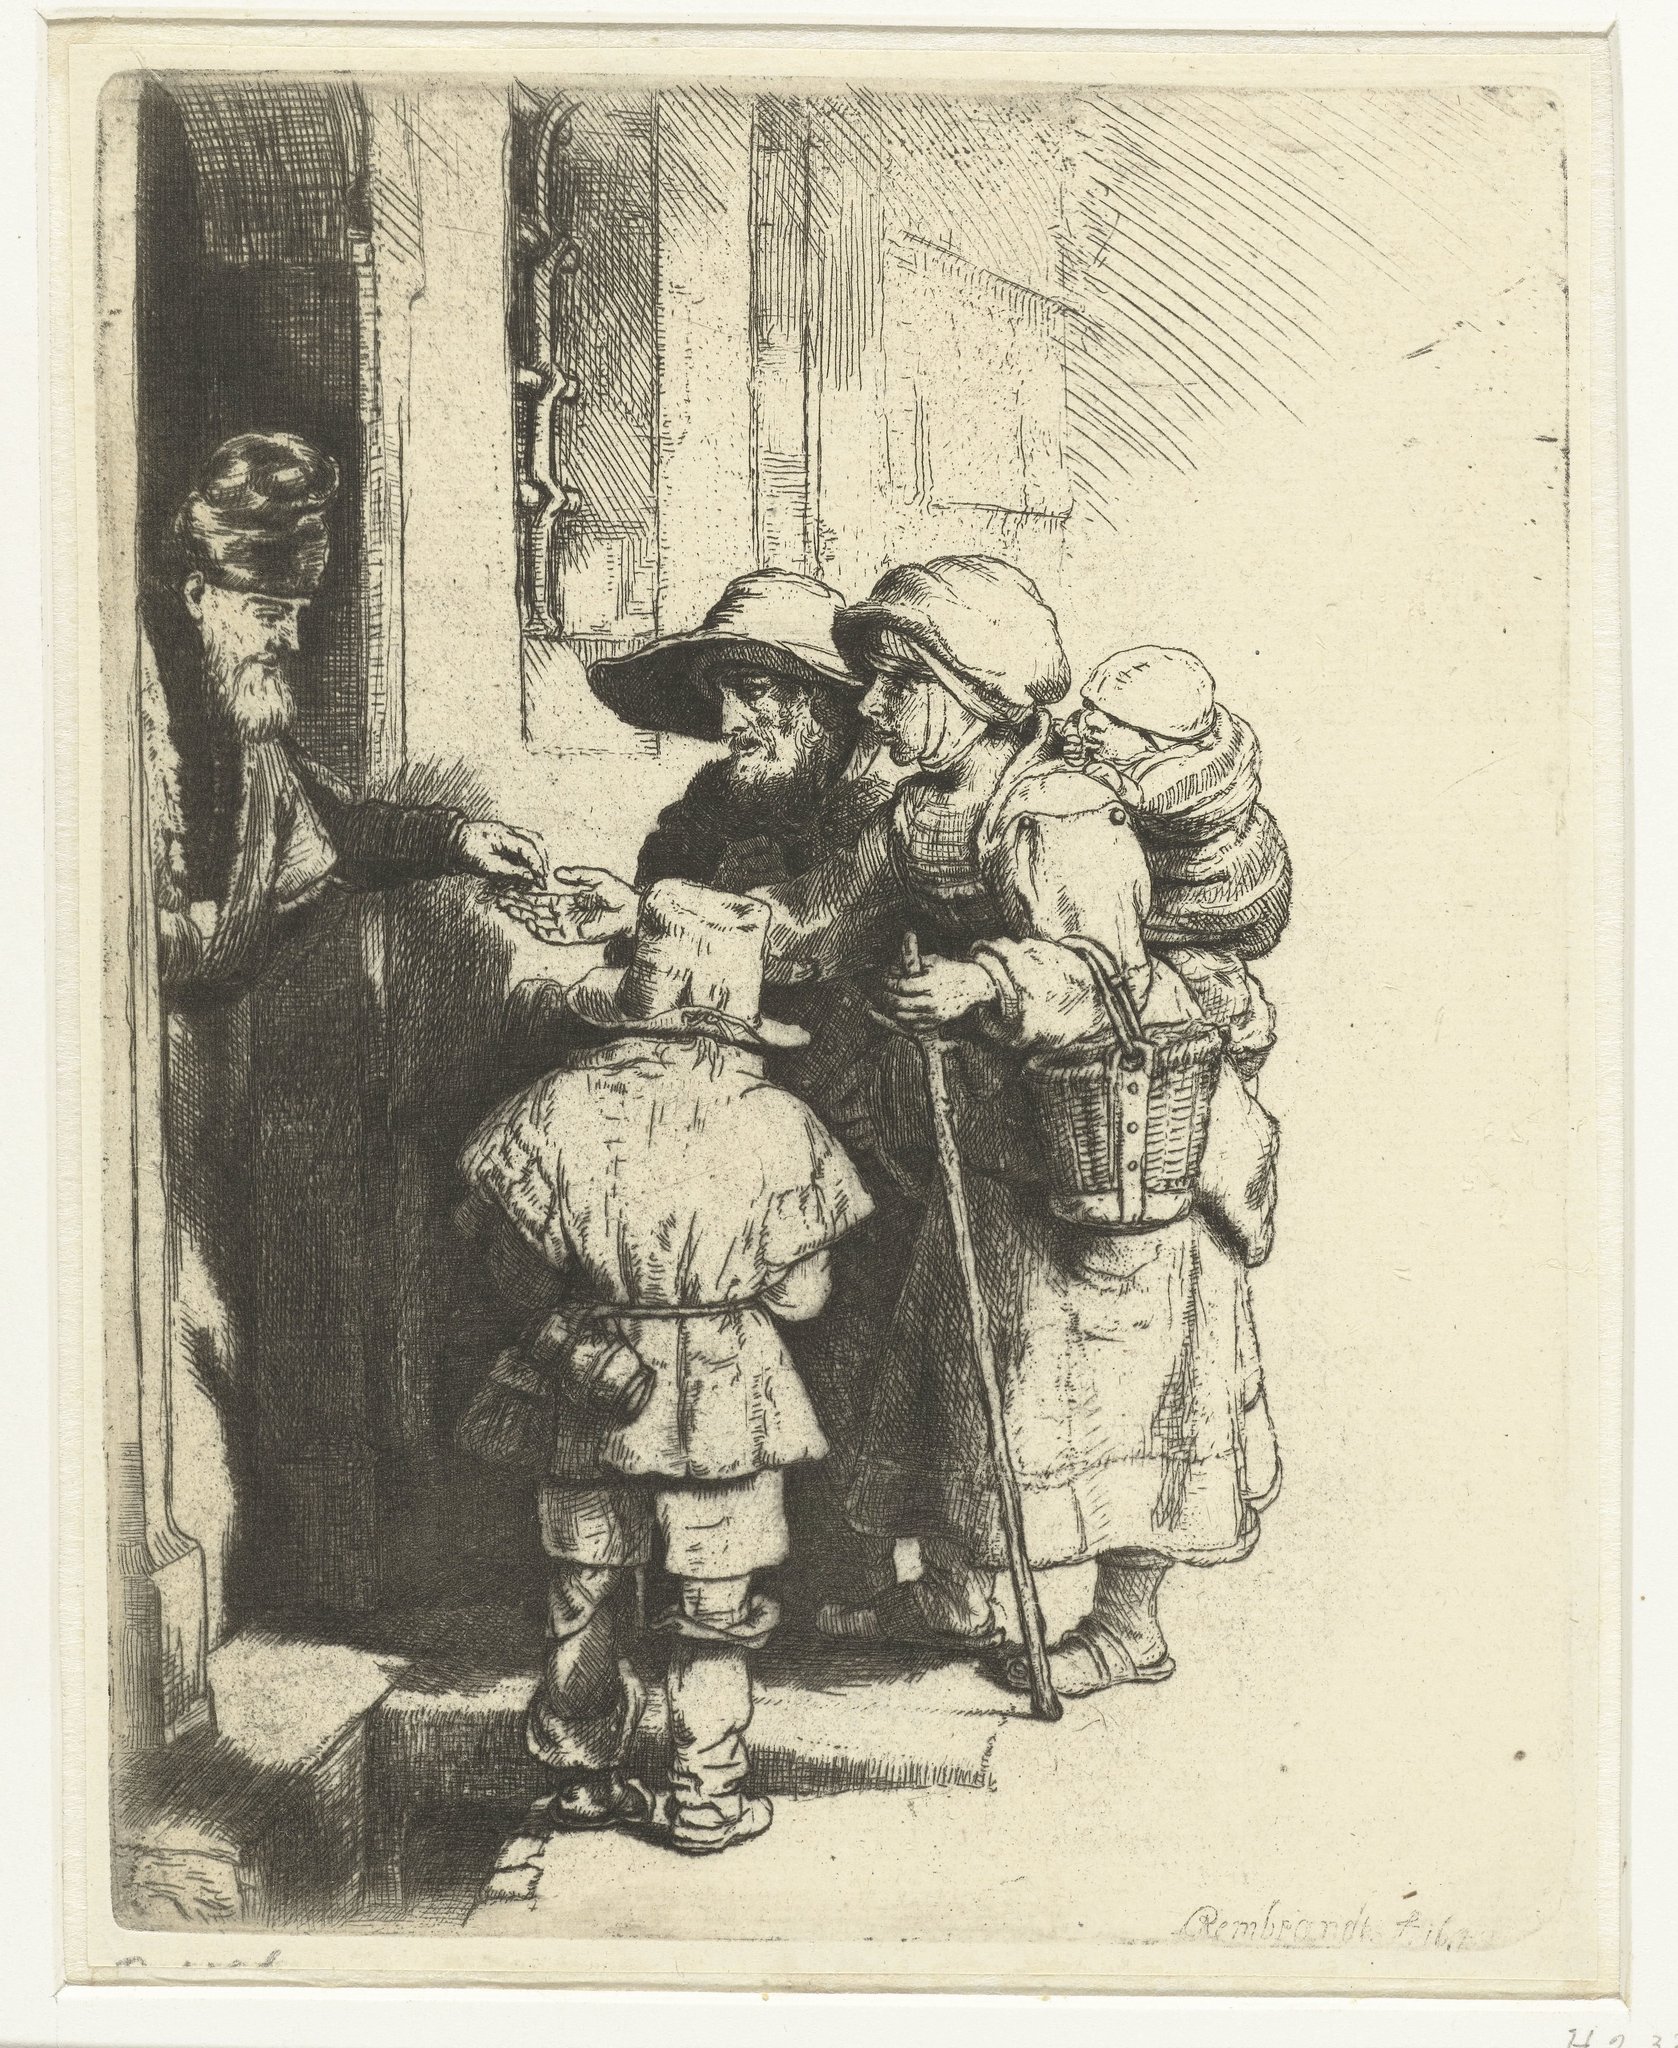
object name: print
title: A blind hurdy-gurdy player and family receiving alms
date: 1648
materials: paper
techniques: drypoint, etching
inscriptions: signature and date: ‘Rembrandt f. 1648’, inscription: ‘Coppier’